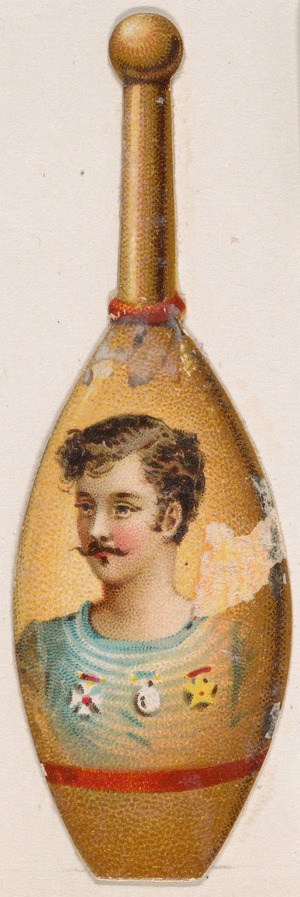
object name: print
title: Indian club, from the Novelties series (N228, Type 3) issued by Kinney Bros.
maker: kinney brothers tobacco company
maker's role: publisher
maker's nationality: american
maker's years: 1869-2011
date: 1889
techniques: color lithograph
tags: men